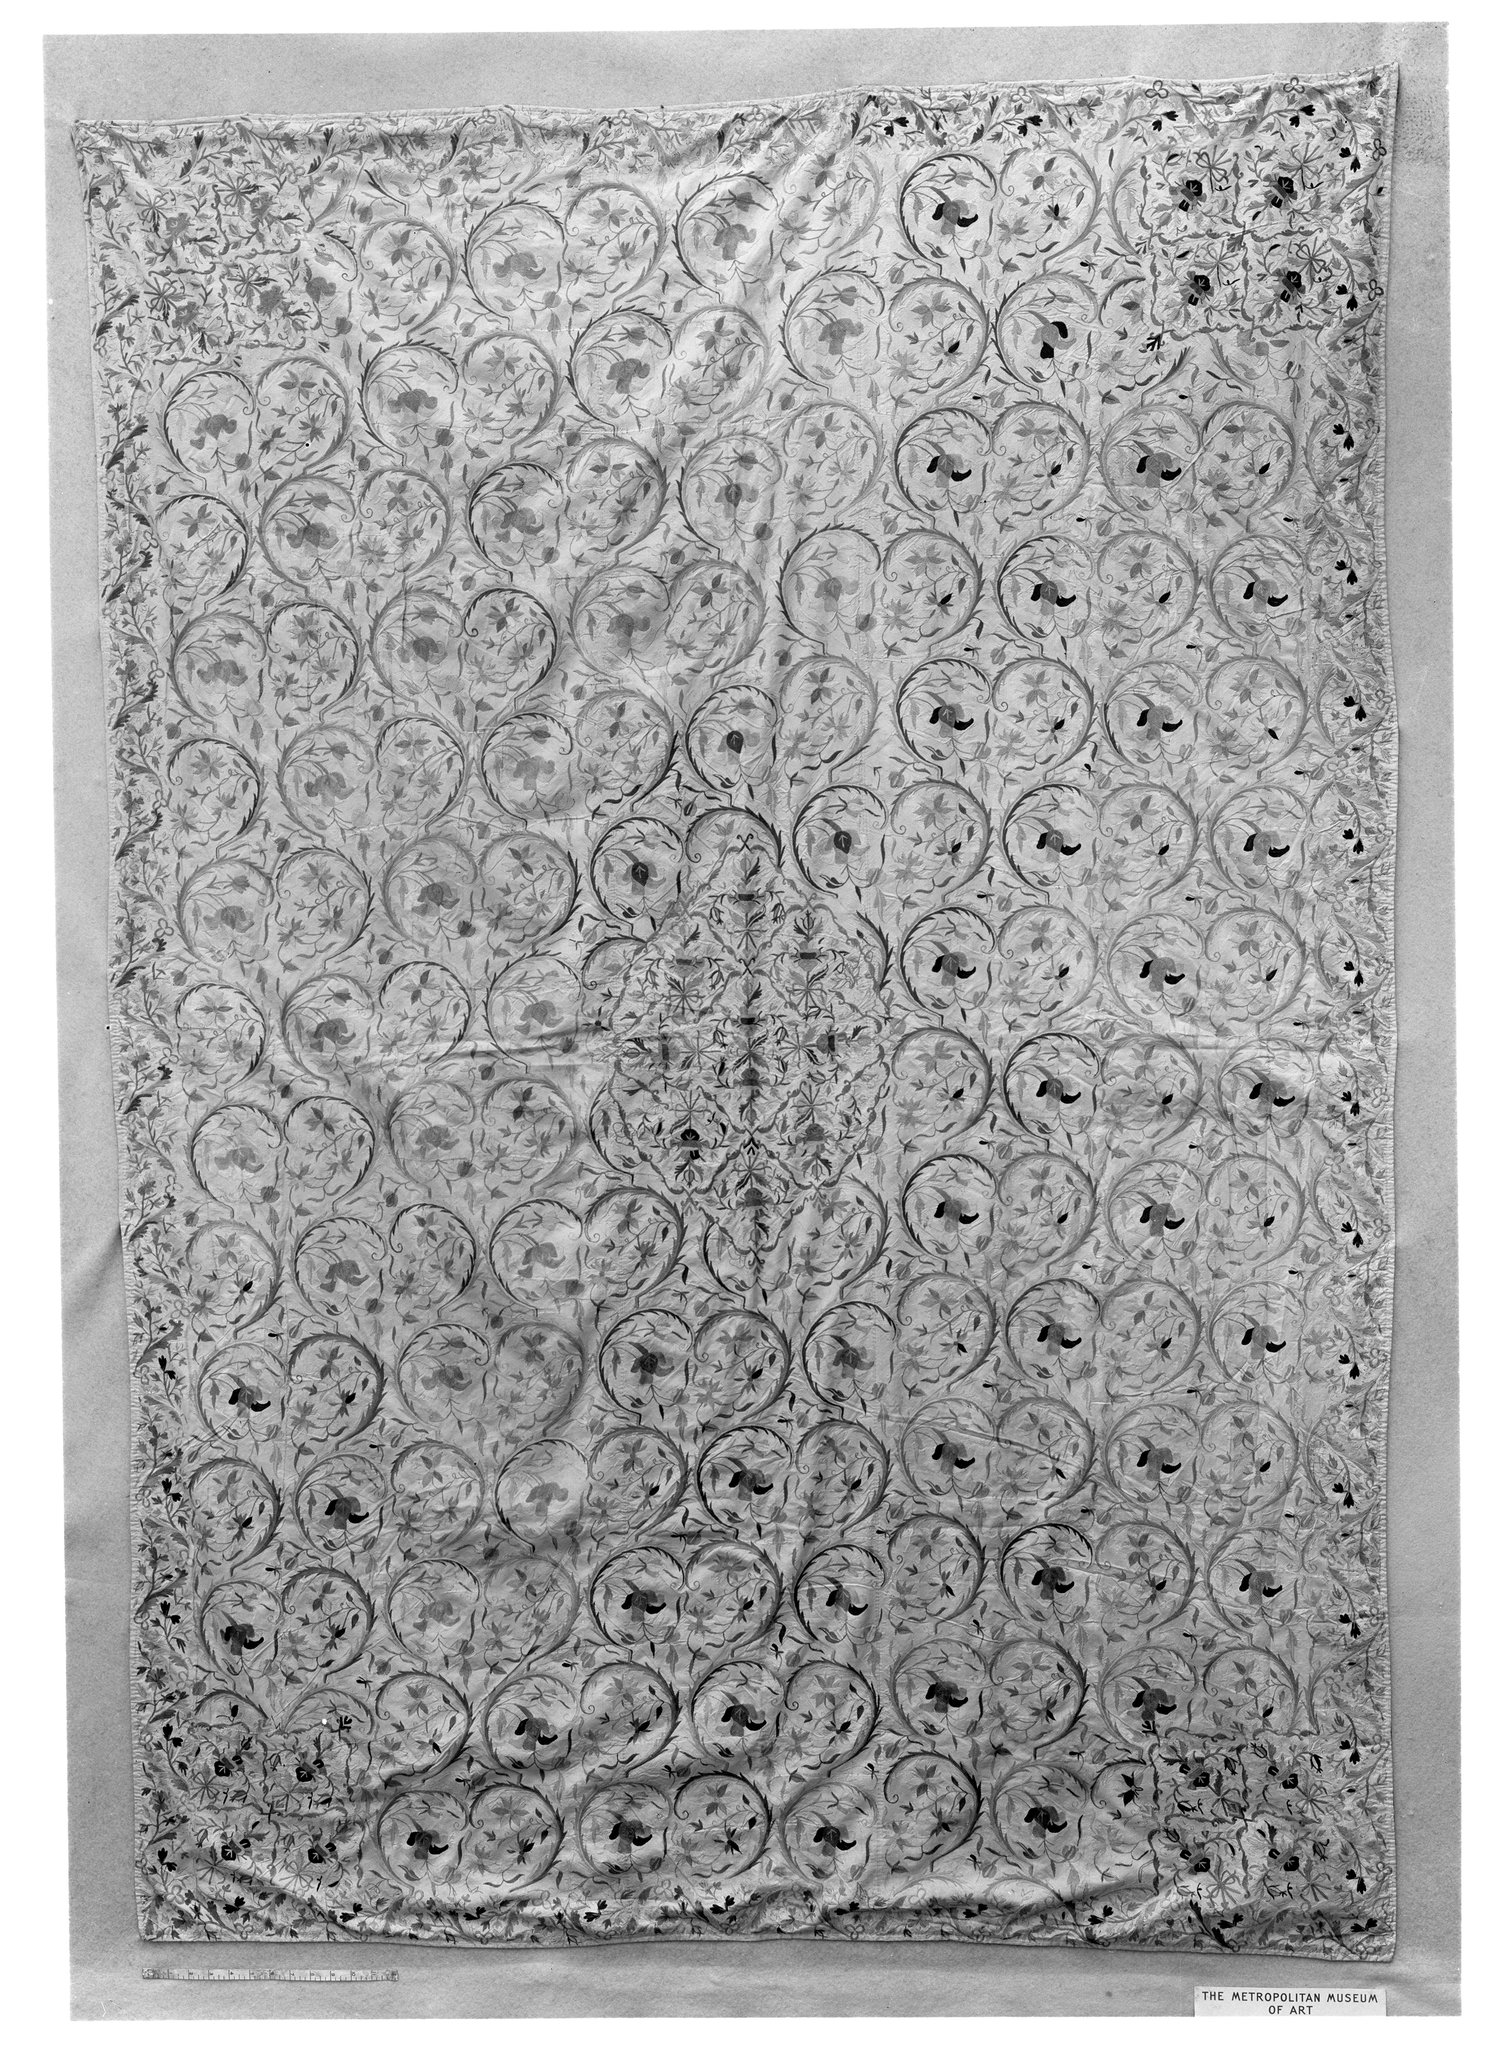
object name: cover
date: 1767-1800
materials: silk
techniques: embroidery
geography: turkey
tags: flowers